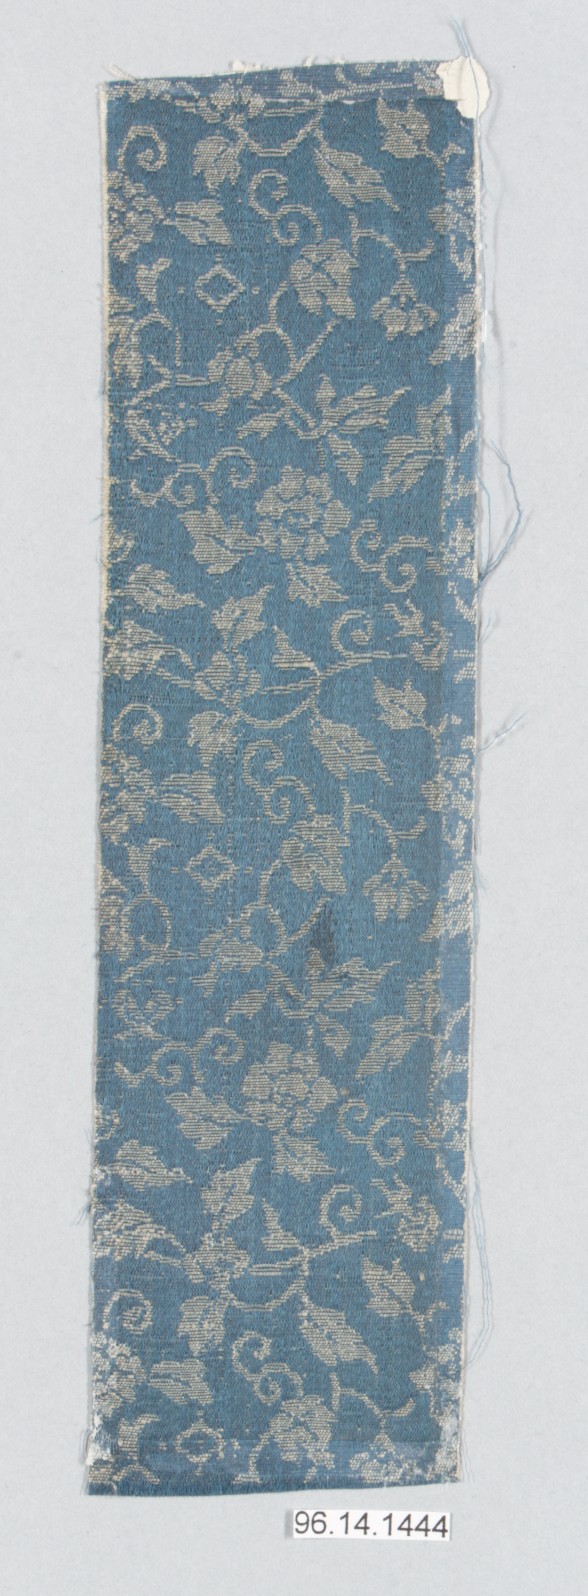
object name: piece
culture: japanese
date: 1801-1900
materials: silk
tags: leaves